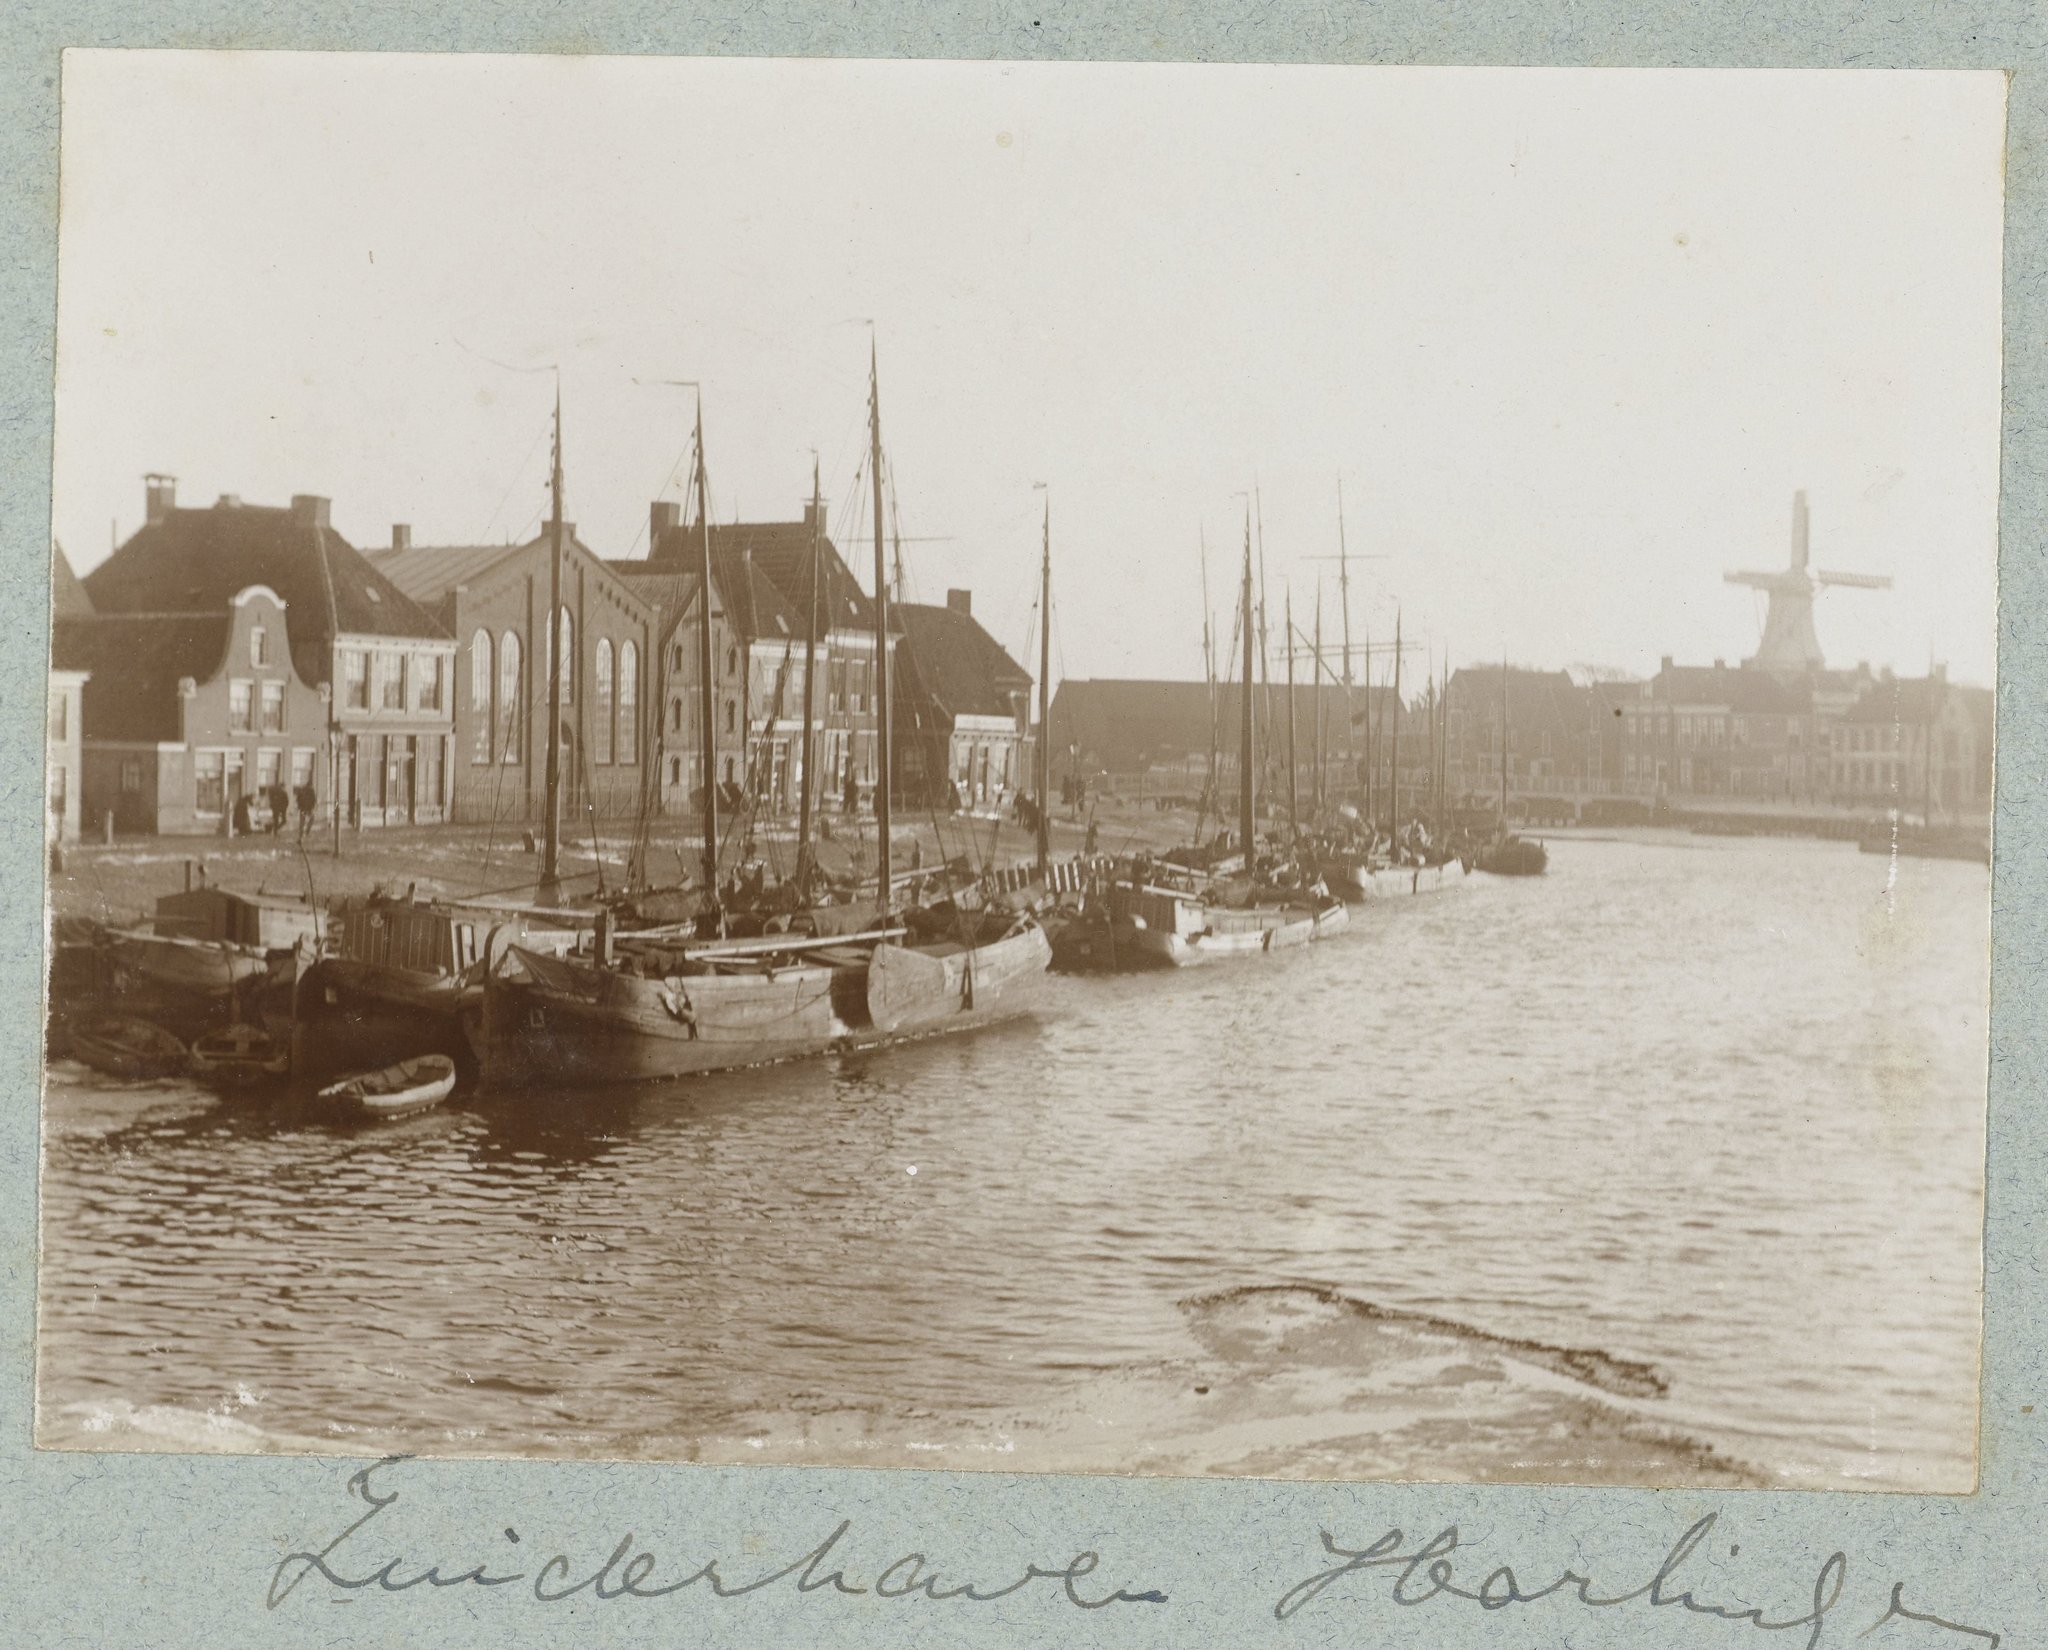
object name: photograph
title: Havengezicht met platbodems en molen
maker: frits freerks fontein fz.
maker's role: fotograaf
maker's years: 1882-1928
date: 1898-1900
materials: cardboard, paper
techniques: gelatin silver print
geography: netherlands